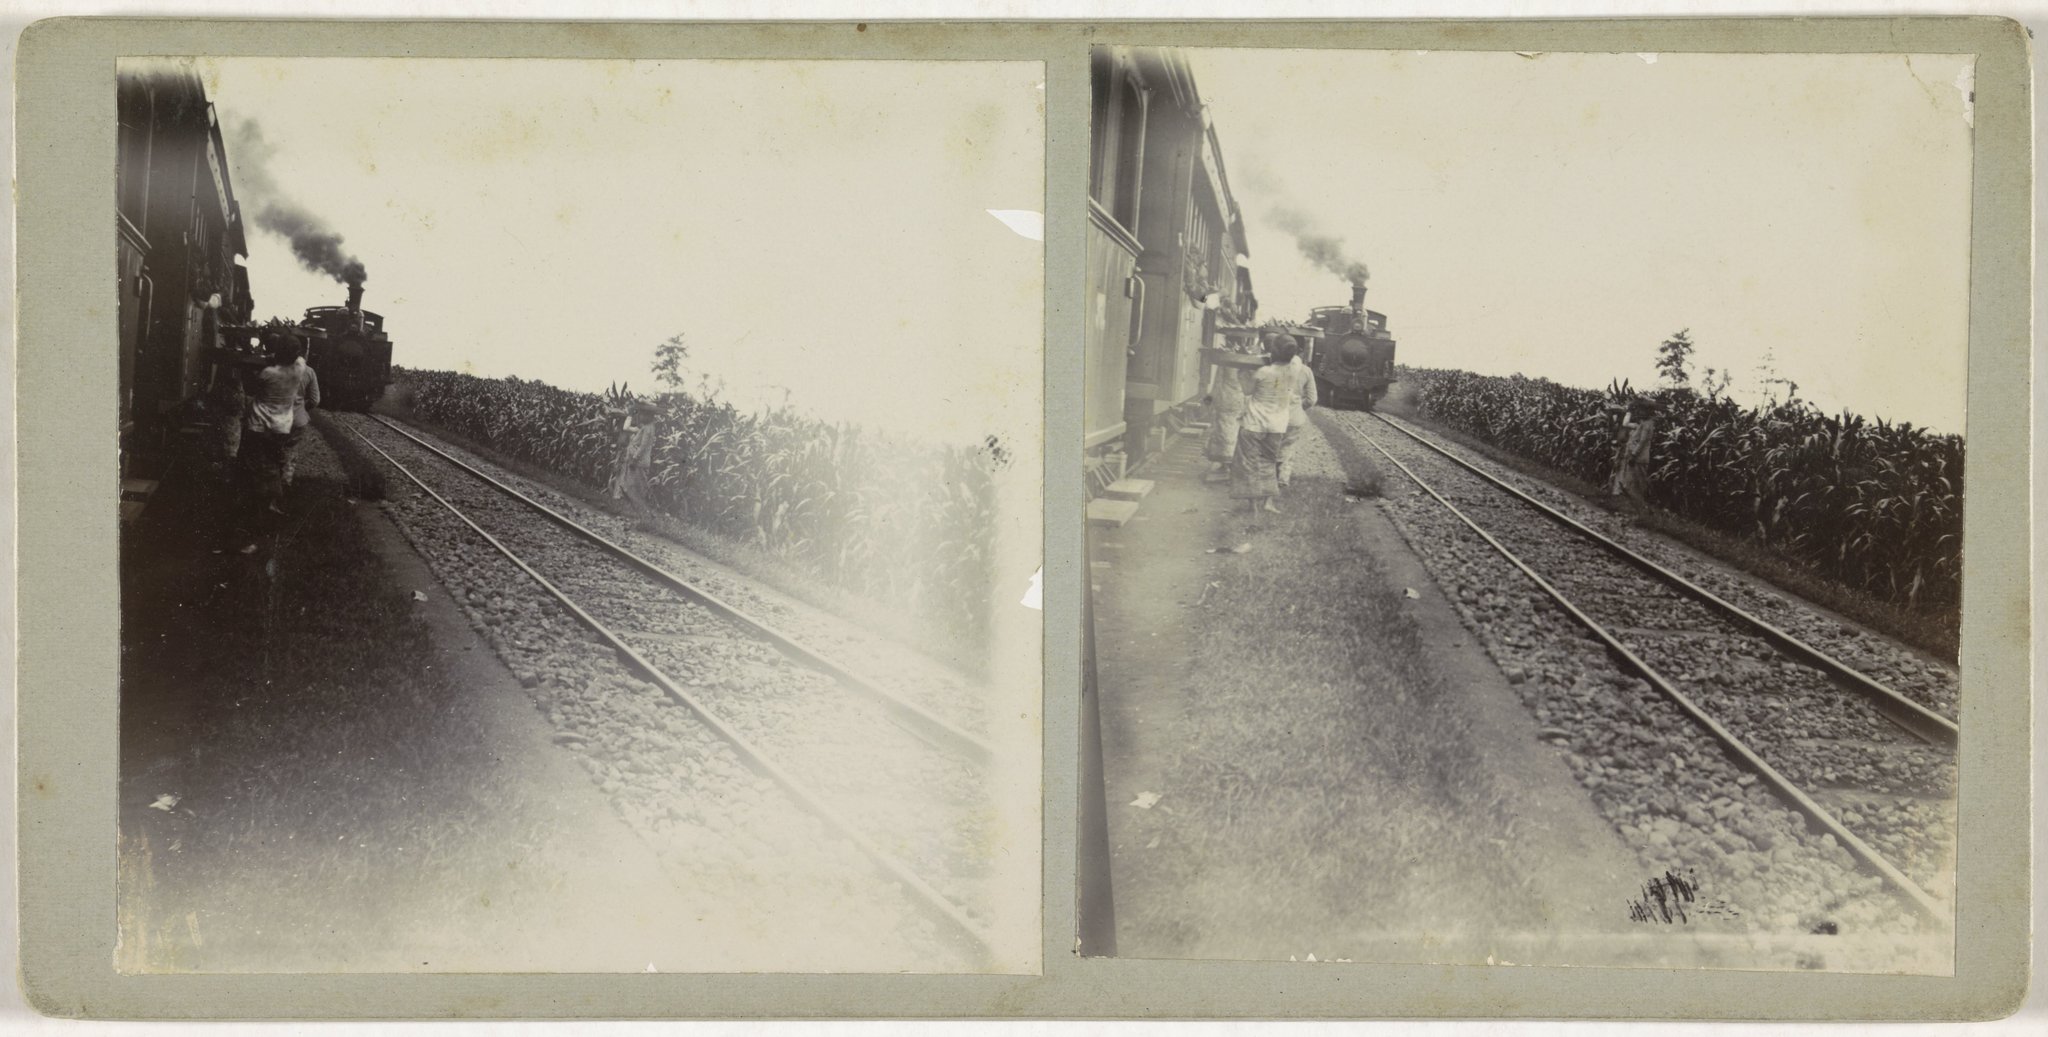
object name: stereograph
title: Vrouwen lopen met manden tussen twee spoorlijnen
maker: Anonymous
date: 1906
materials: cardboard, paper, photographic support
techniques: collodion silver print